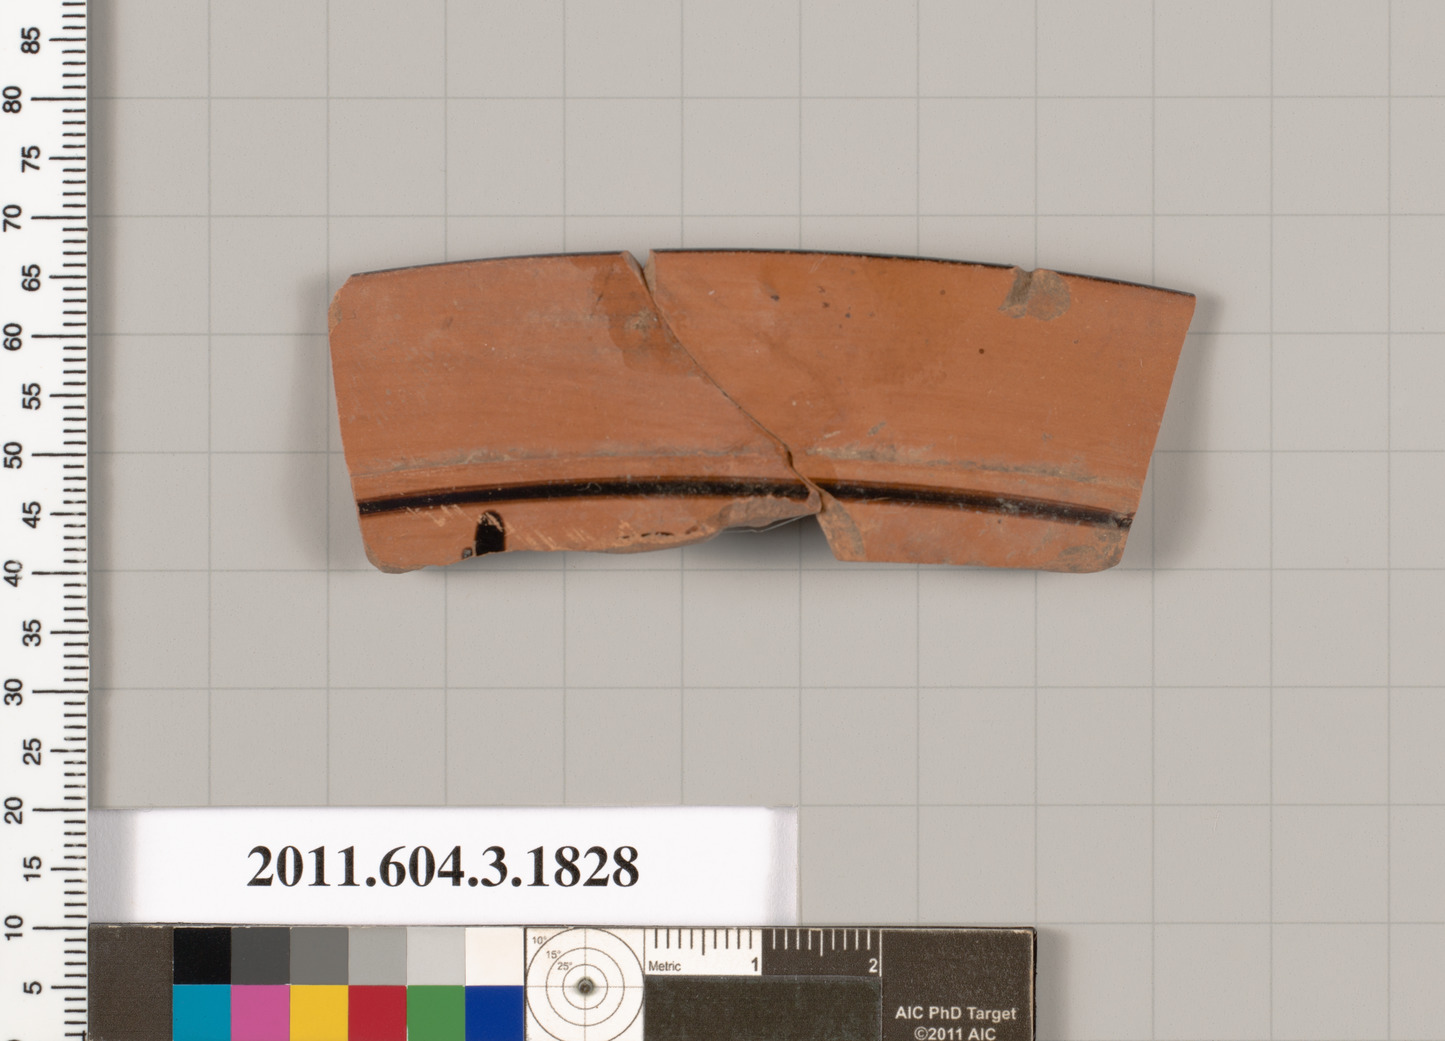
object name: kylix fragment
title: Terracotta fragment of a kylix: Lip cup (drinking cup)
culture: greek, attic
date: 560-525 BCE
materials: terracotta